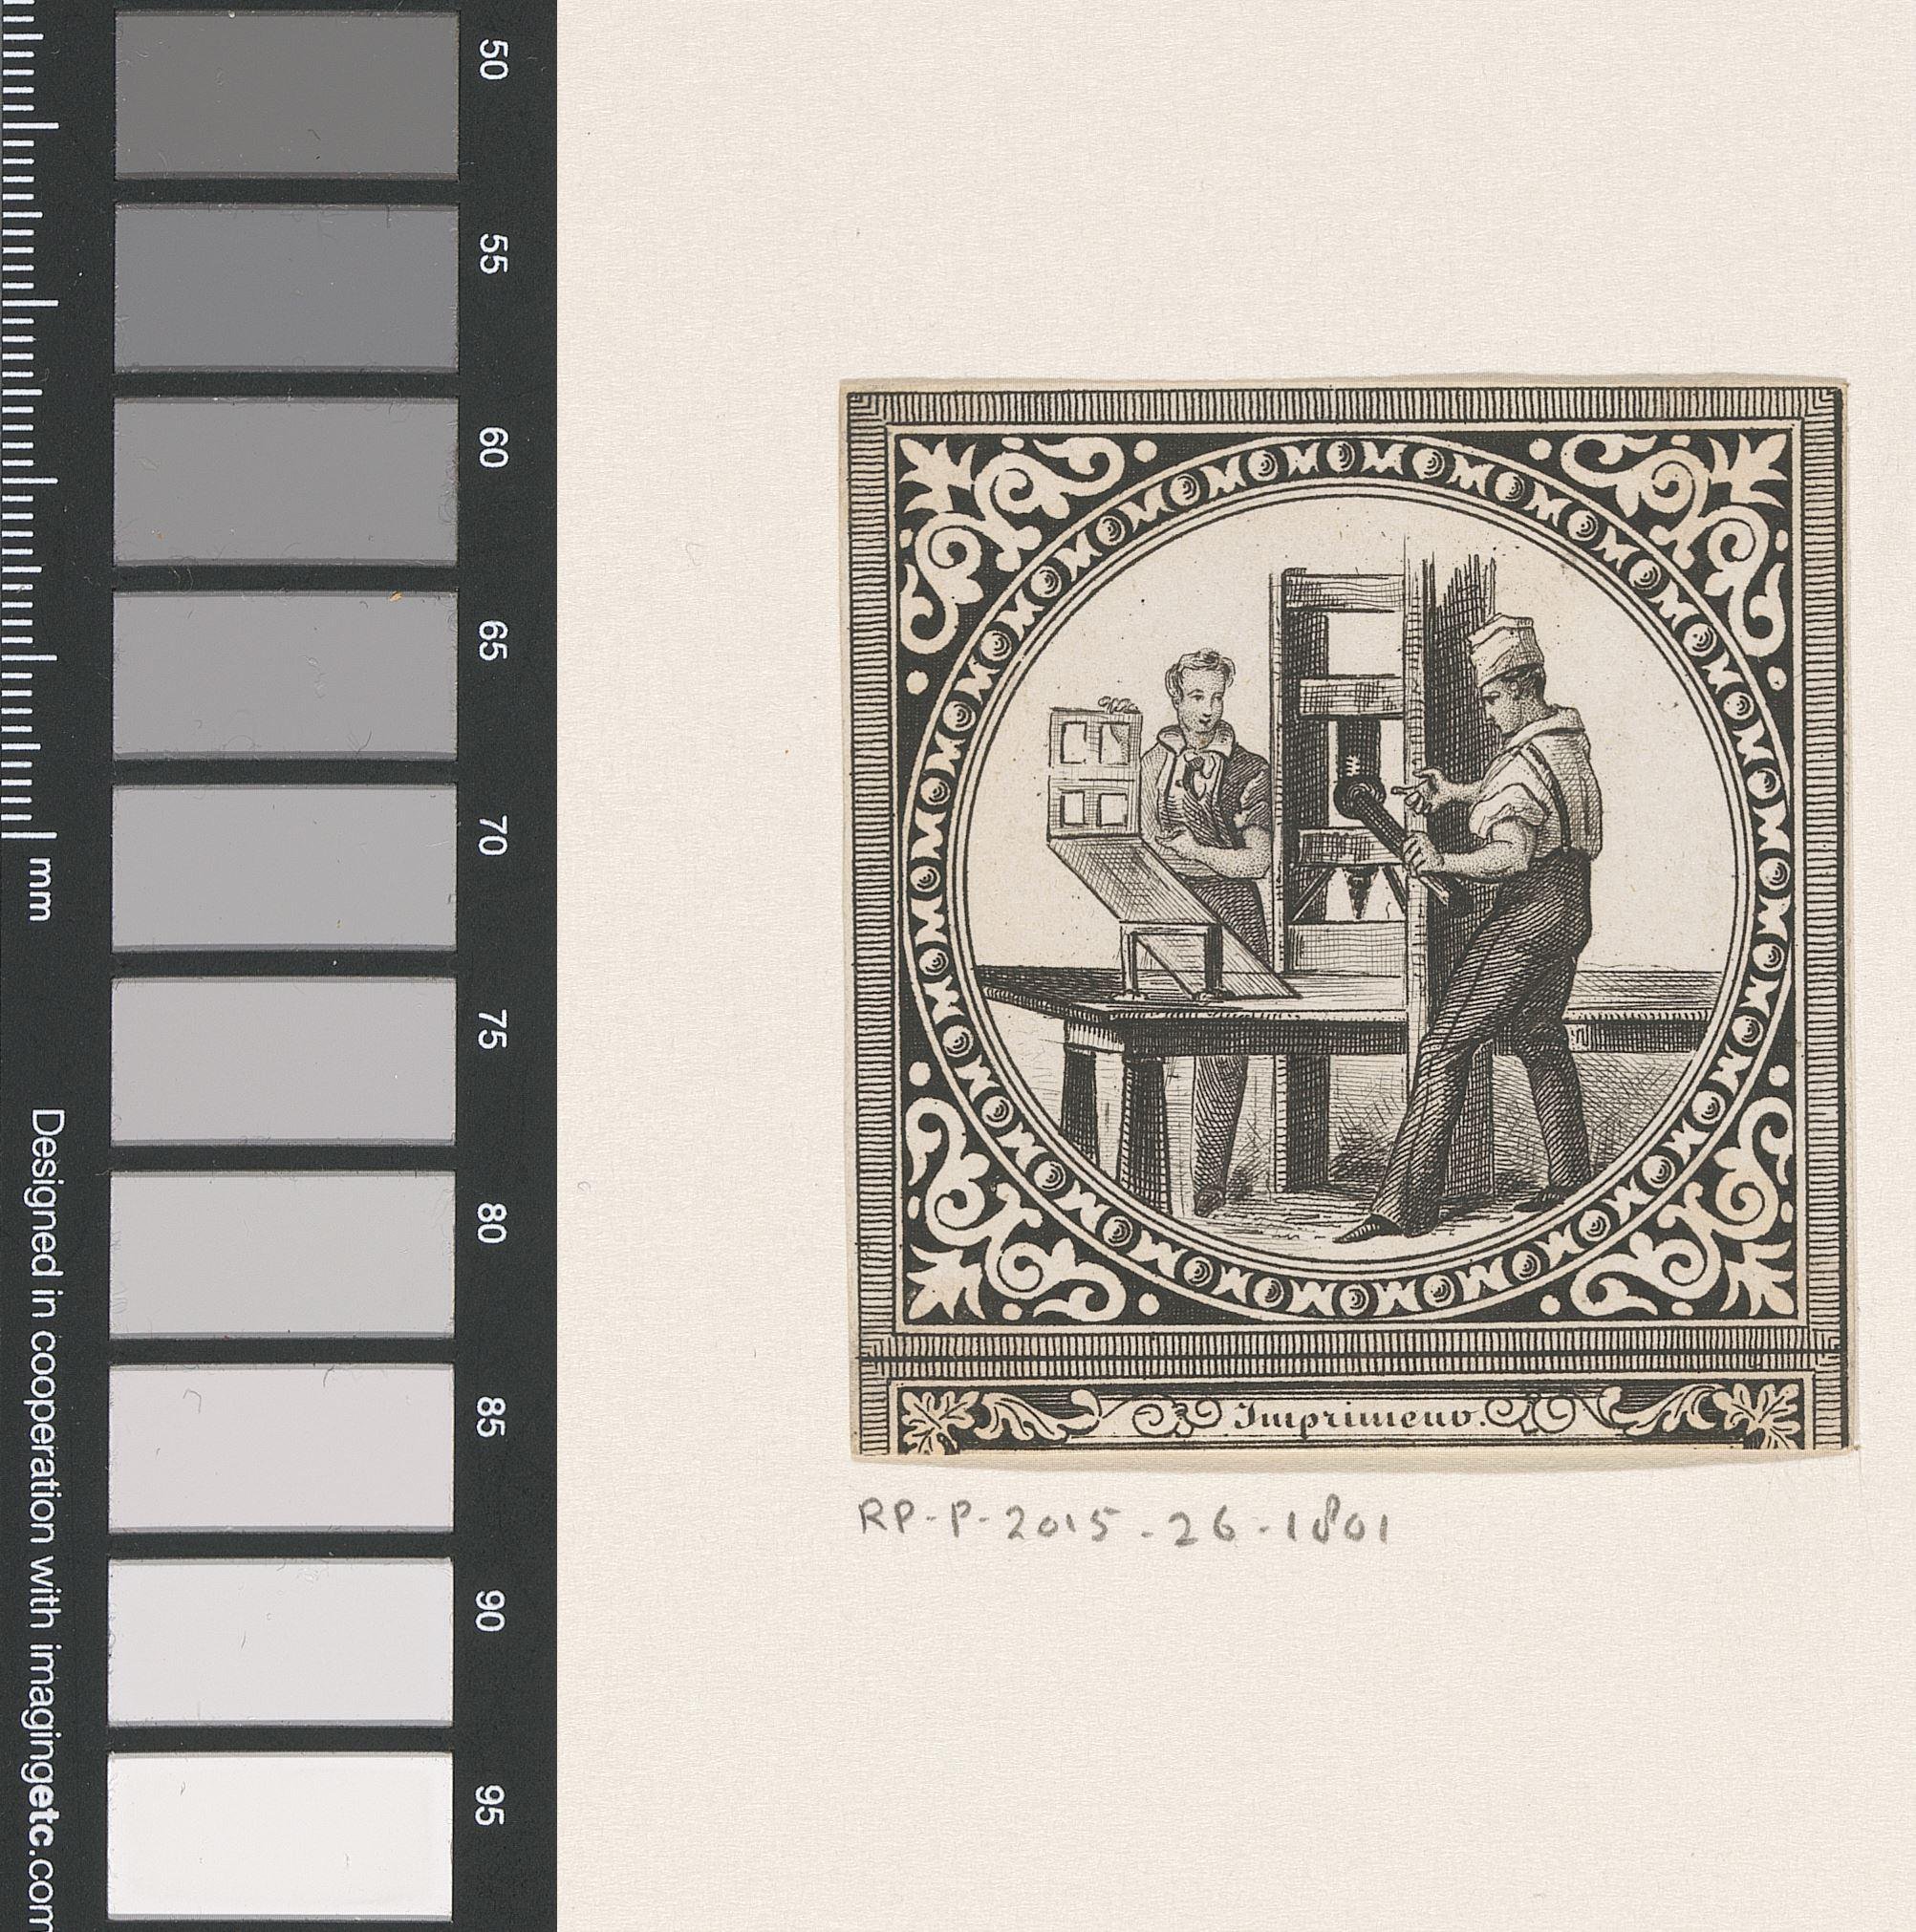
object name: print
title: Boekdrukker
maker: Anonymous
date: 1800-1899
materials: paper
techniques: etching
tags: printing press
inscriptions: collector's mark: Lugt 2228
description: Twee mannen bedienen een boekdrukpers. Ronde voorstelling in een omlijsting.